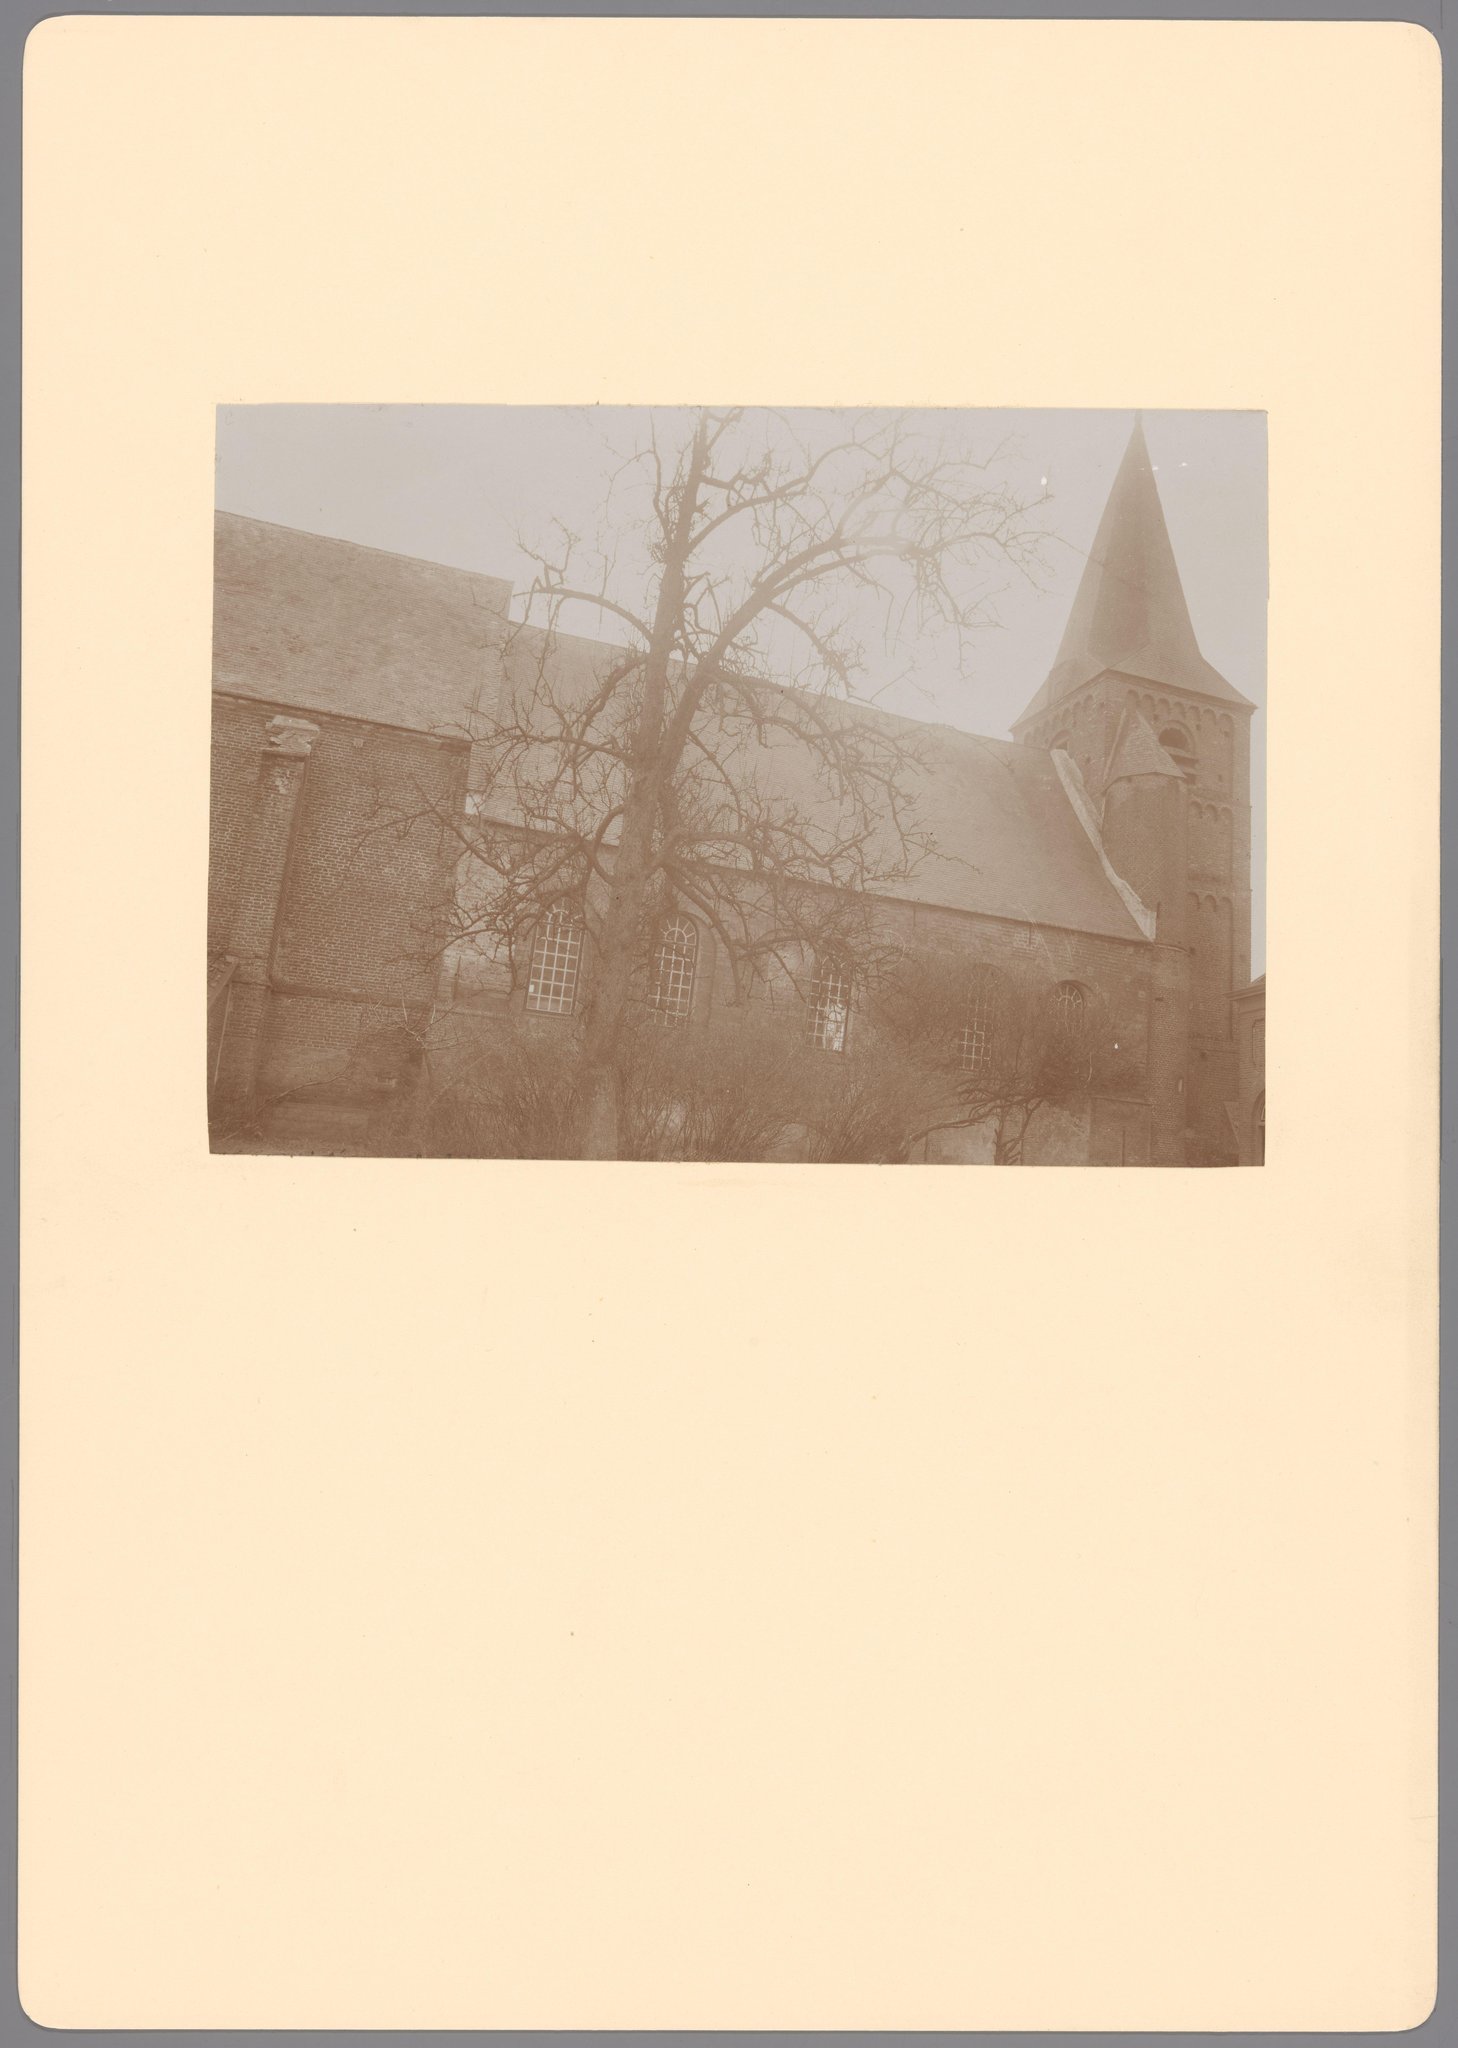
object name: photograph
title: Gezicht op de Hervormde Kerk te Kerkwijk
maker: anoniem (monumentenzorg)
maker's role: fotograaf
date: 1890-1920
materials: cardboard, photographic support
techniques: collodion silver print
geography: kerkwijk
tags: church (exterior)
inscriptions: annotation: ‘Kerkwijk Gelderland/ Kerk der N.H. gem.’